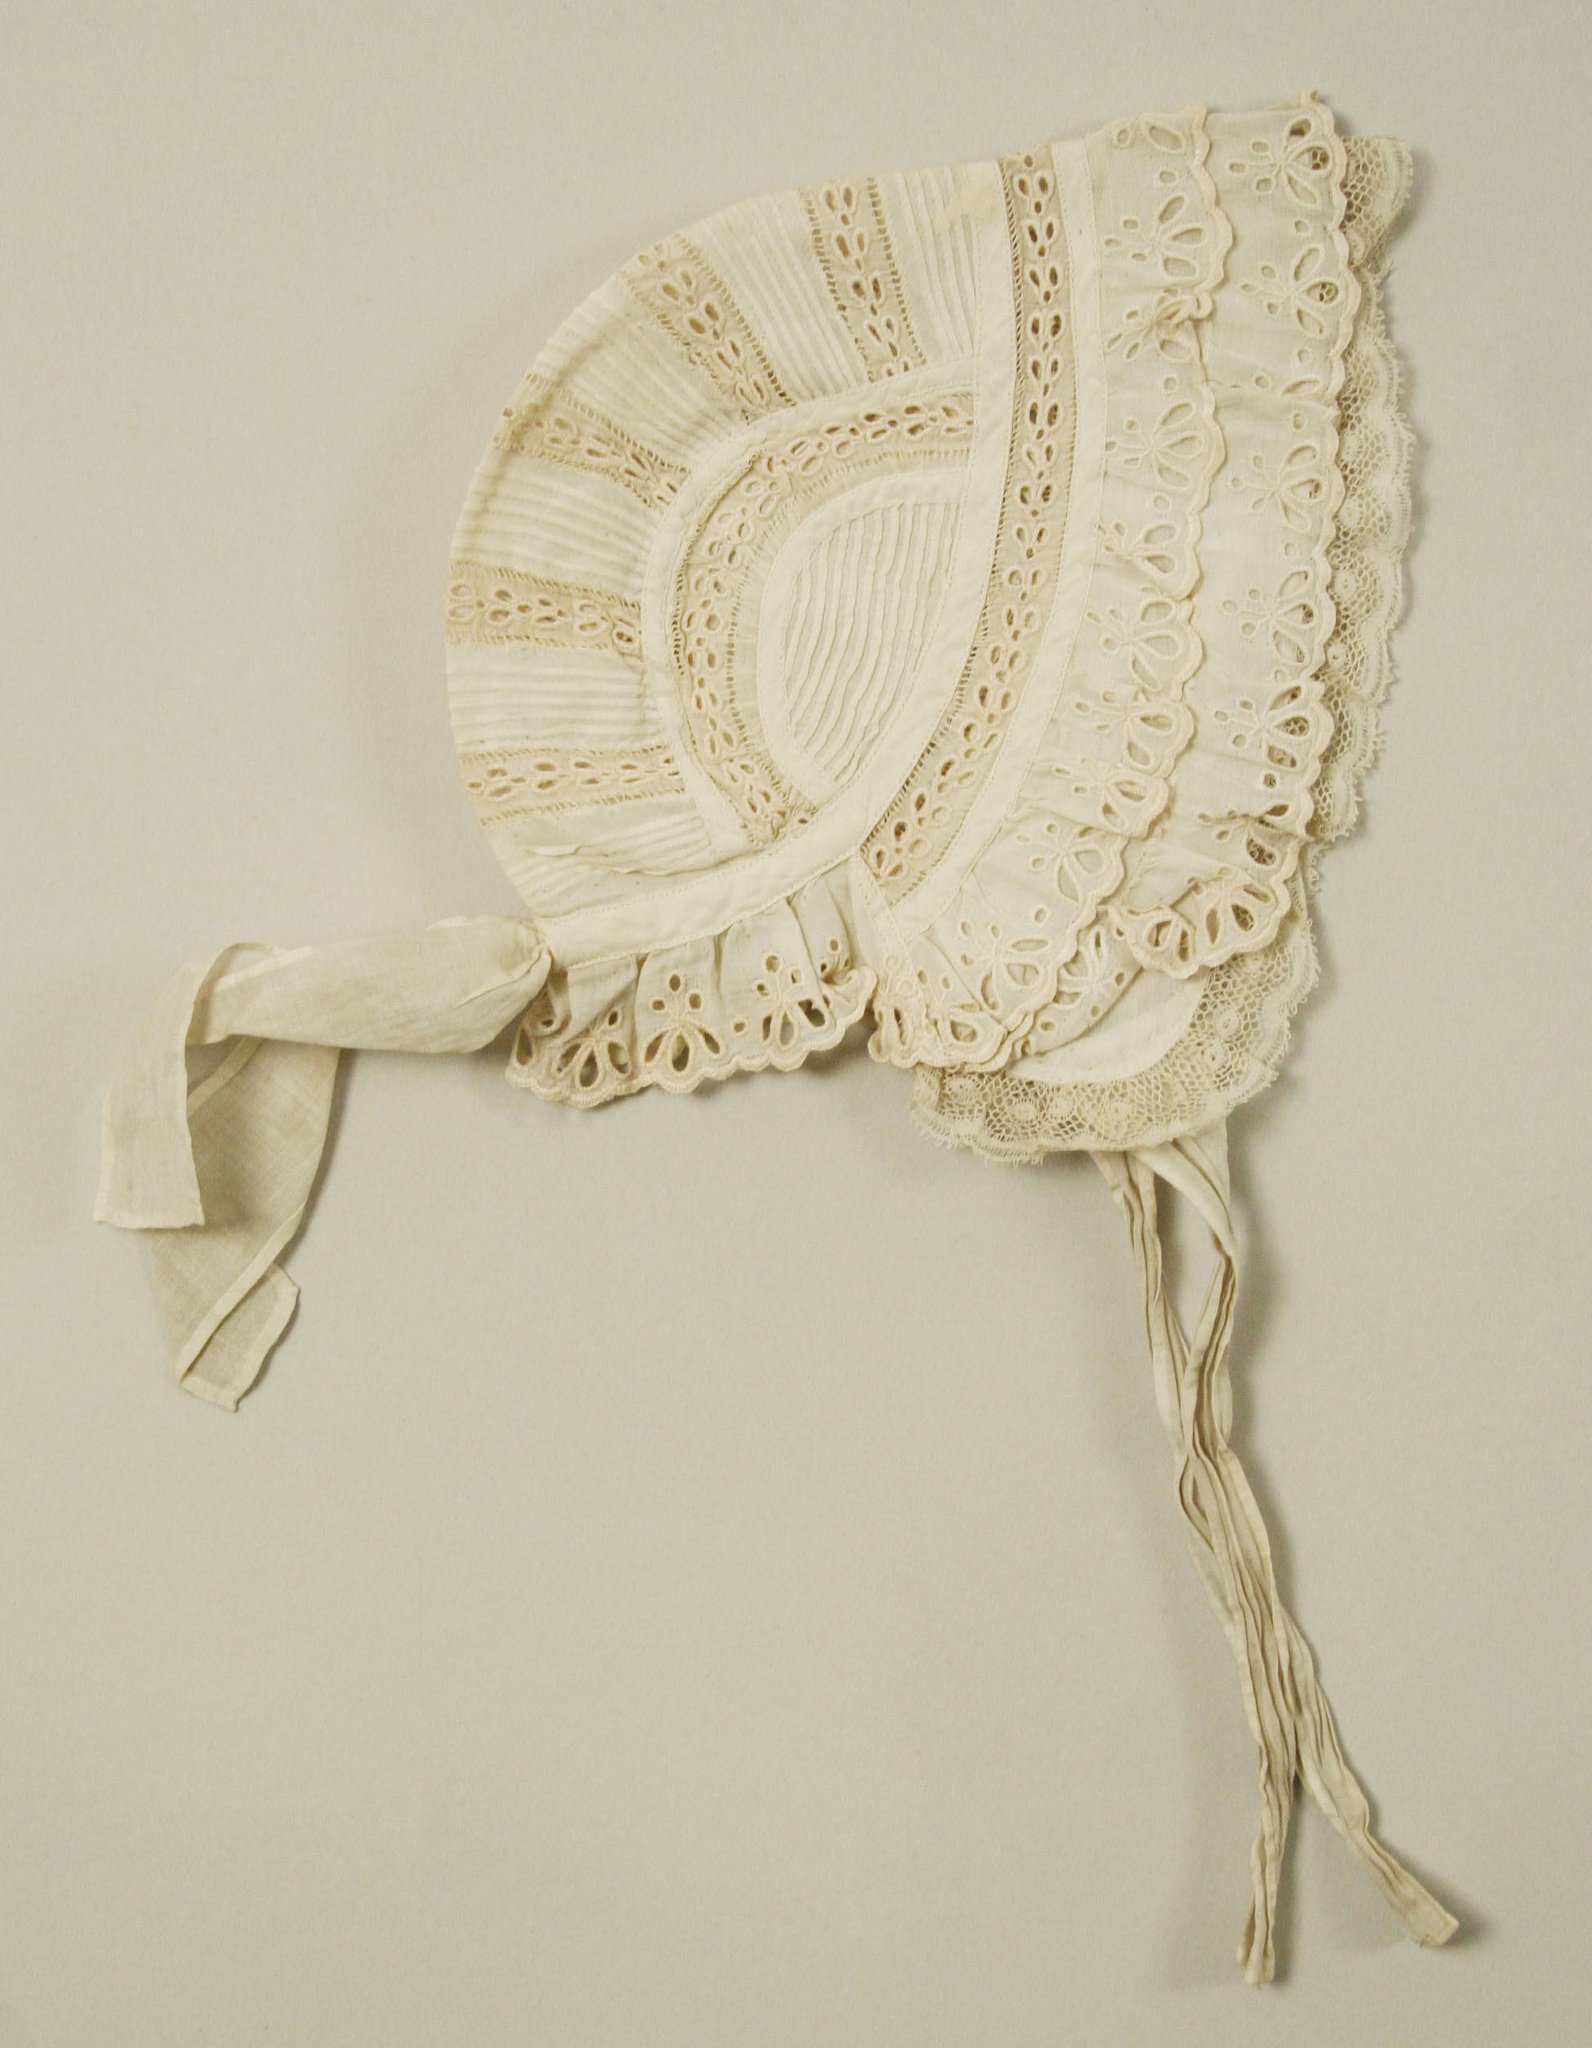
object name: cap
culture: british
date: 1801-1900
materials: cotton